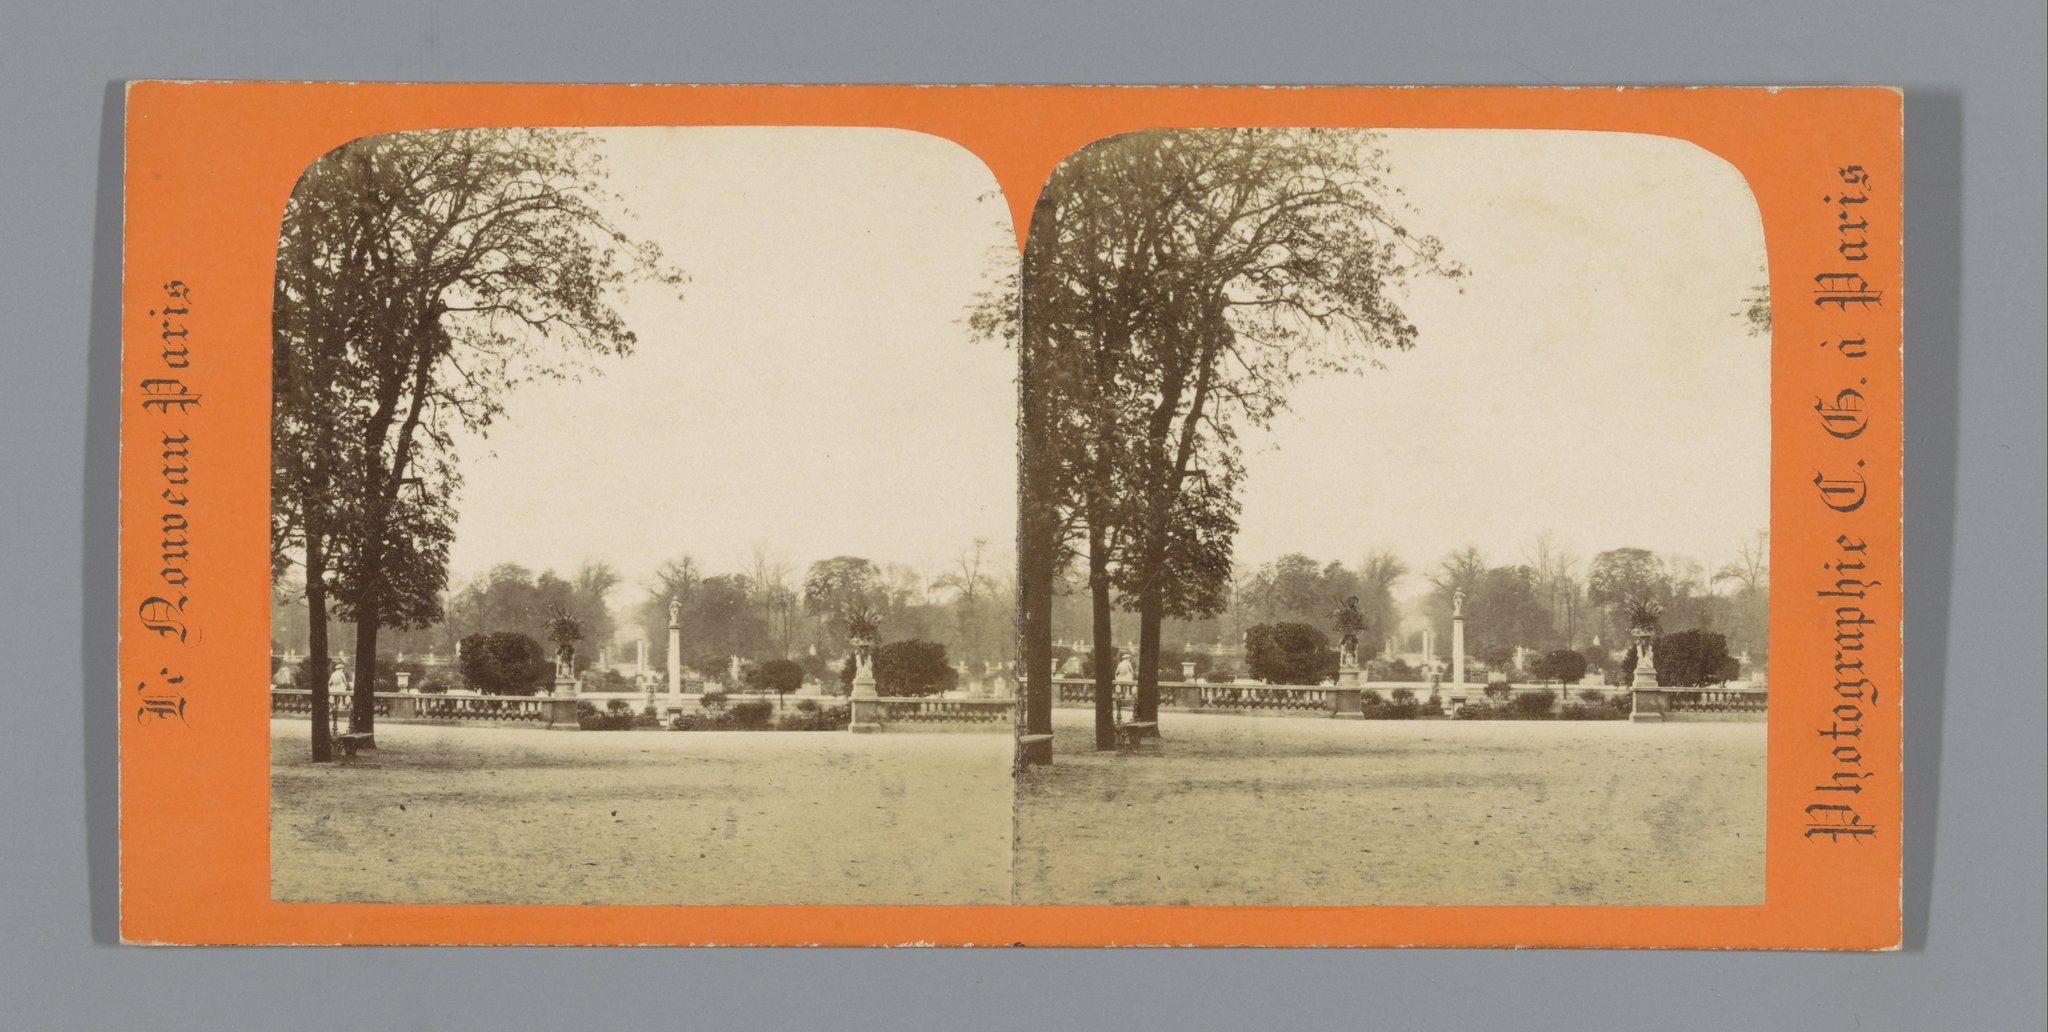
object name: stereograph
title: Jardin du Luxembourg te Parijs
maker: charles gérard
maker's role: fotograaf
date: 1850-1875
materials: cardboard, photographic support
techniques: albumen print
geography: jardin du luxembourg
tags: garden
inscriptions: inscription: ‘Le Luxembourg’